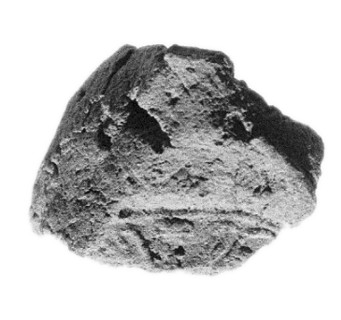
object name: sealing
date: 1981-1640 BCE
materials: mud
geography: egypt